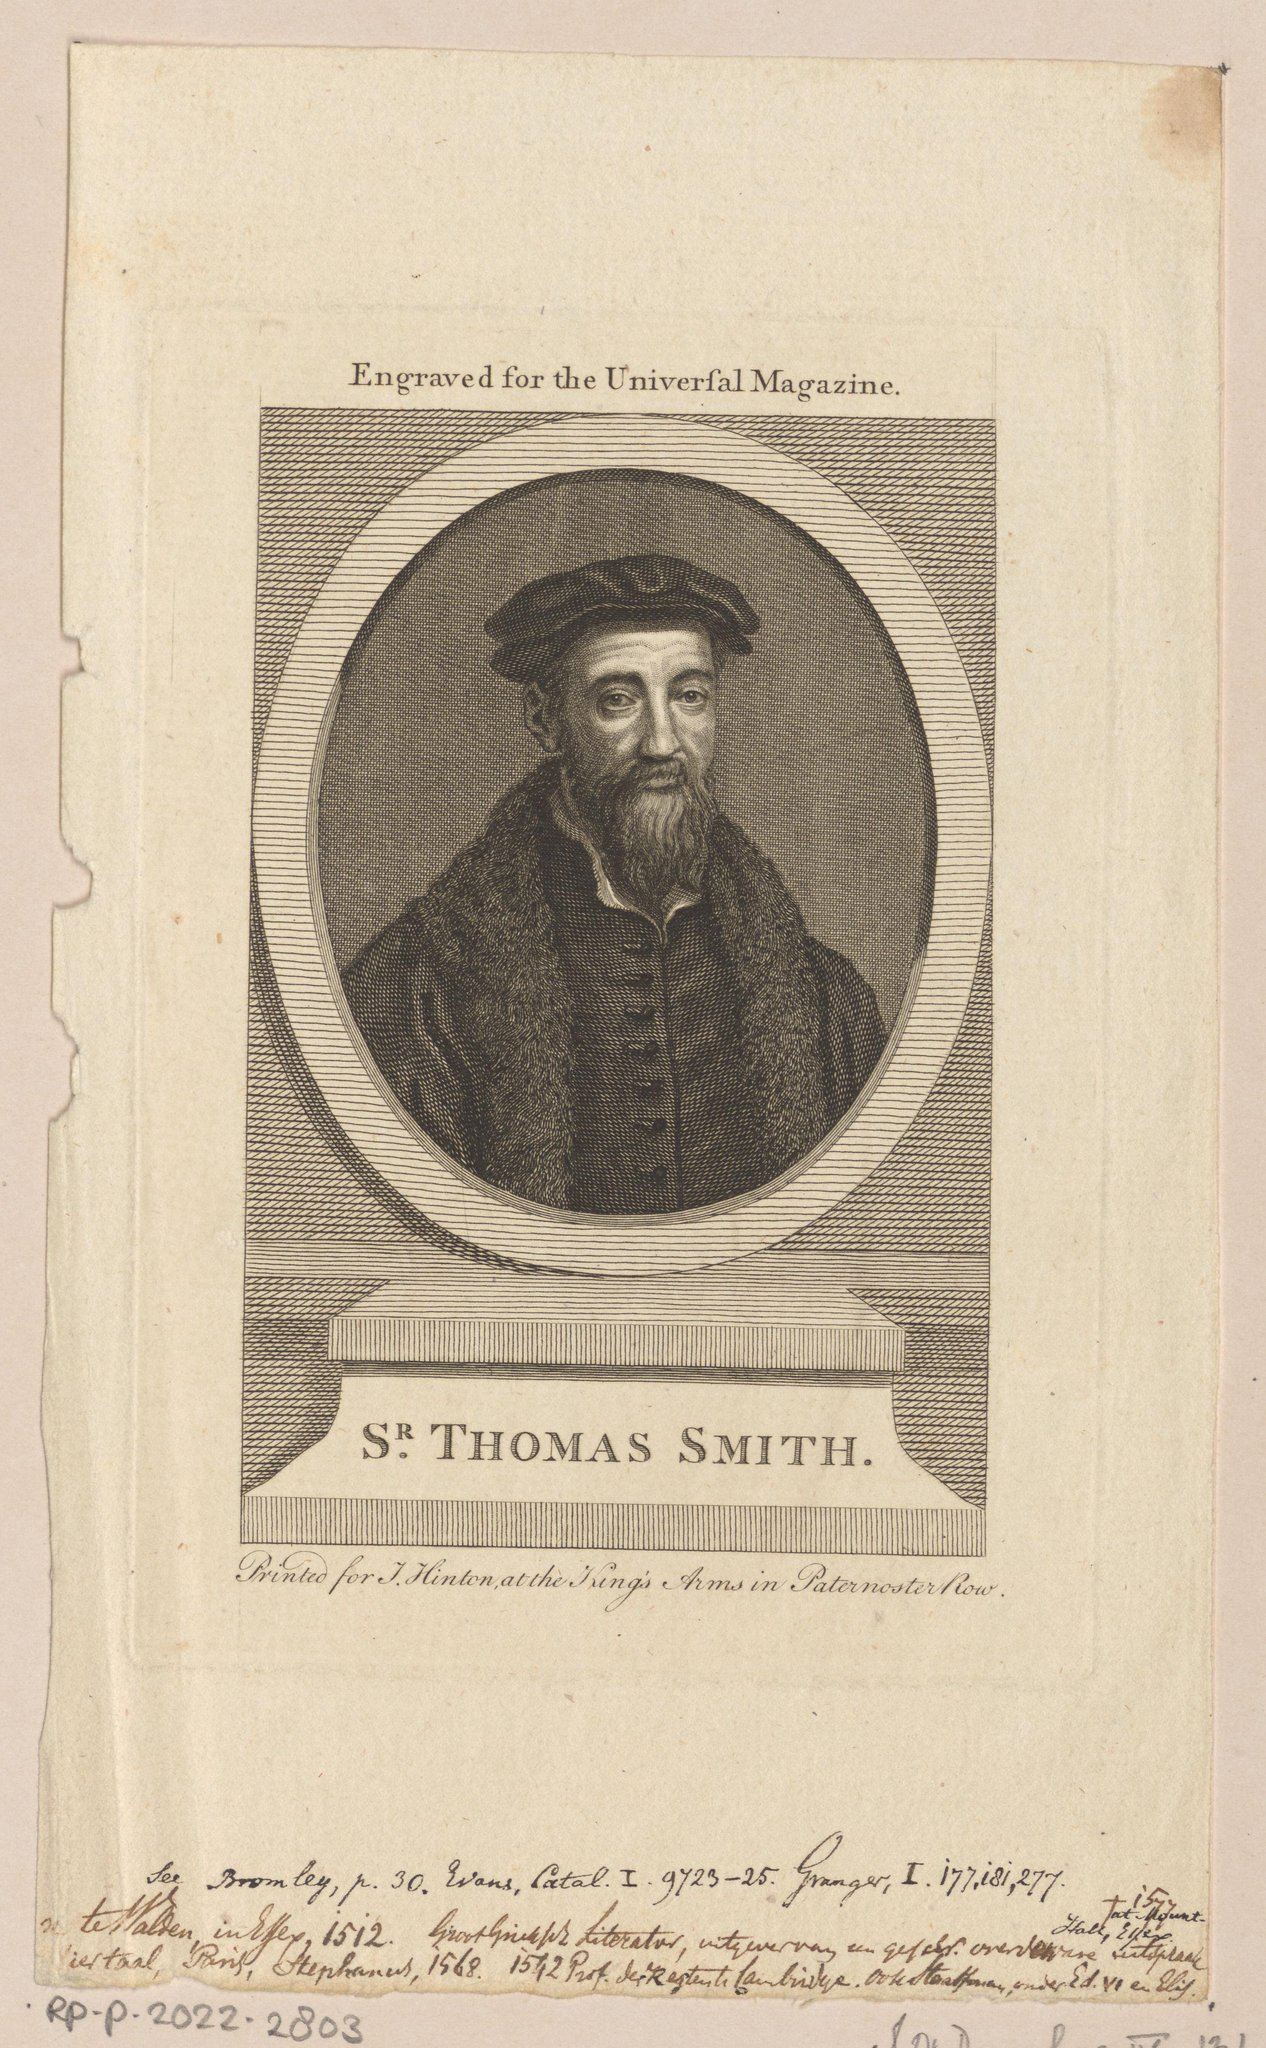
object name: print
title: Portret van Thomas Smith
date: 1747-1814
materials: paper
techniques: engraving, etching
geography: london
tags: historical persons, diplomacy, diplomat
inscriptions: inscription: ‘See Bromley, p. (...) Ed. VI en Elis.’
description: Prent uit een uitgave van The Universal Magazine for Knowledge and Pleasure [1747-1813].